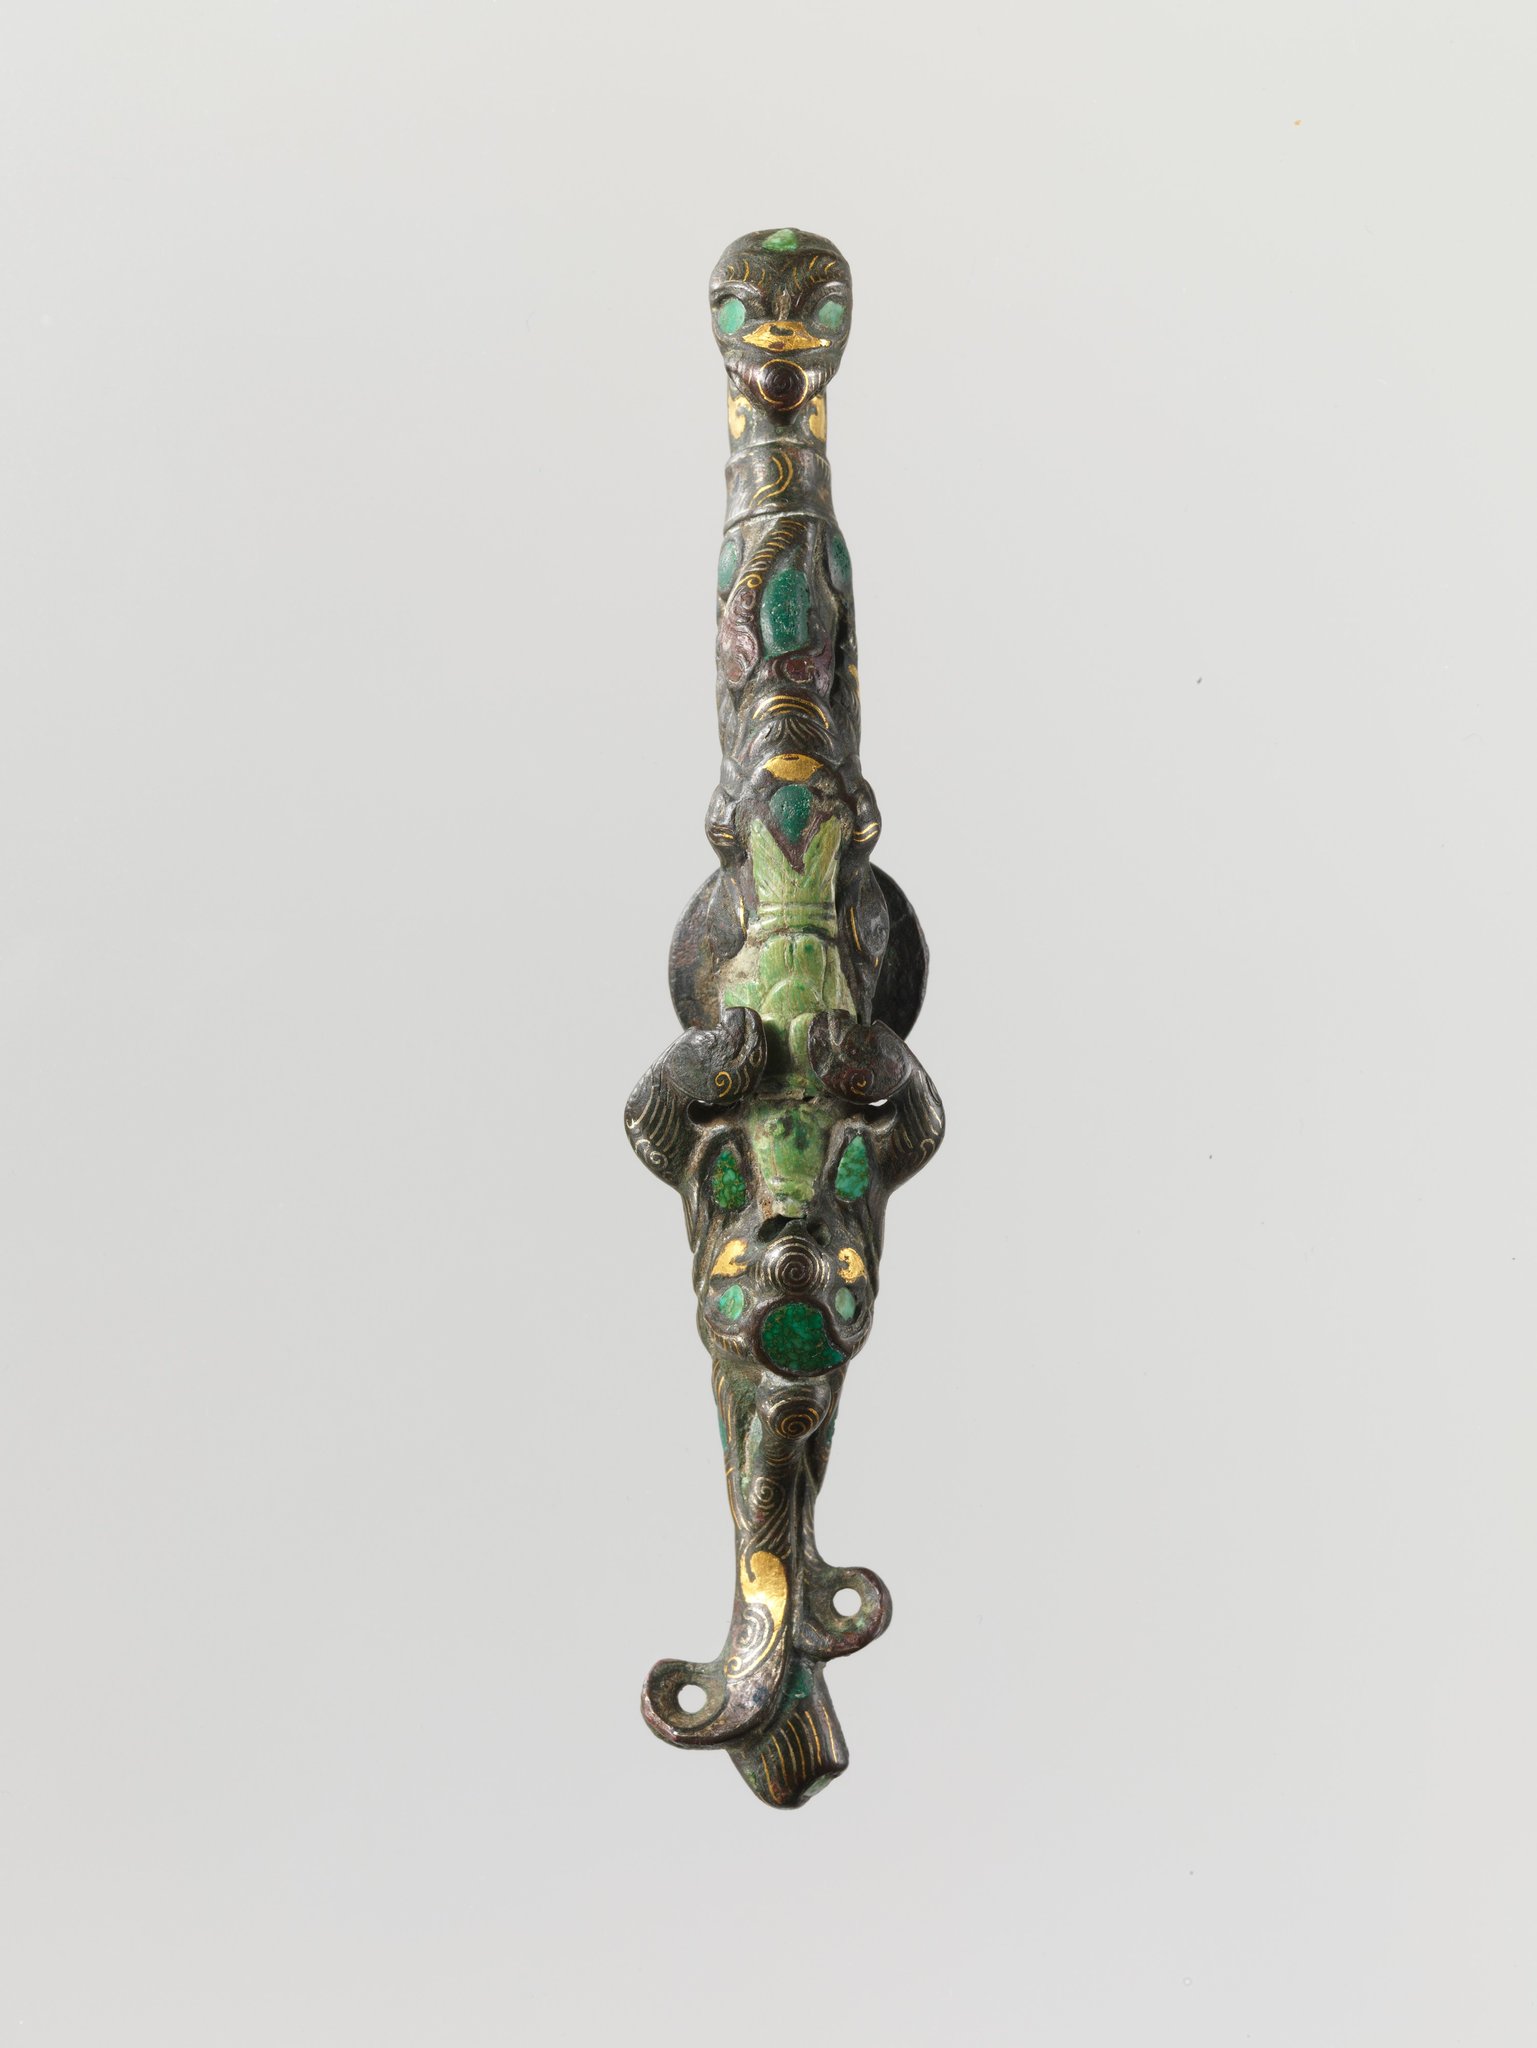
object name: belt hook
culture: chinese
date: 201-300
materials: bronze, gold, ivory, silver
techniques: inlay